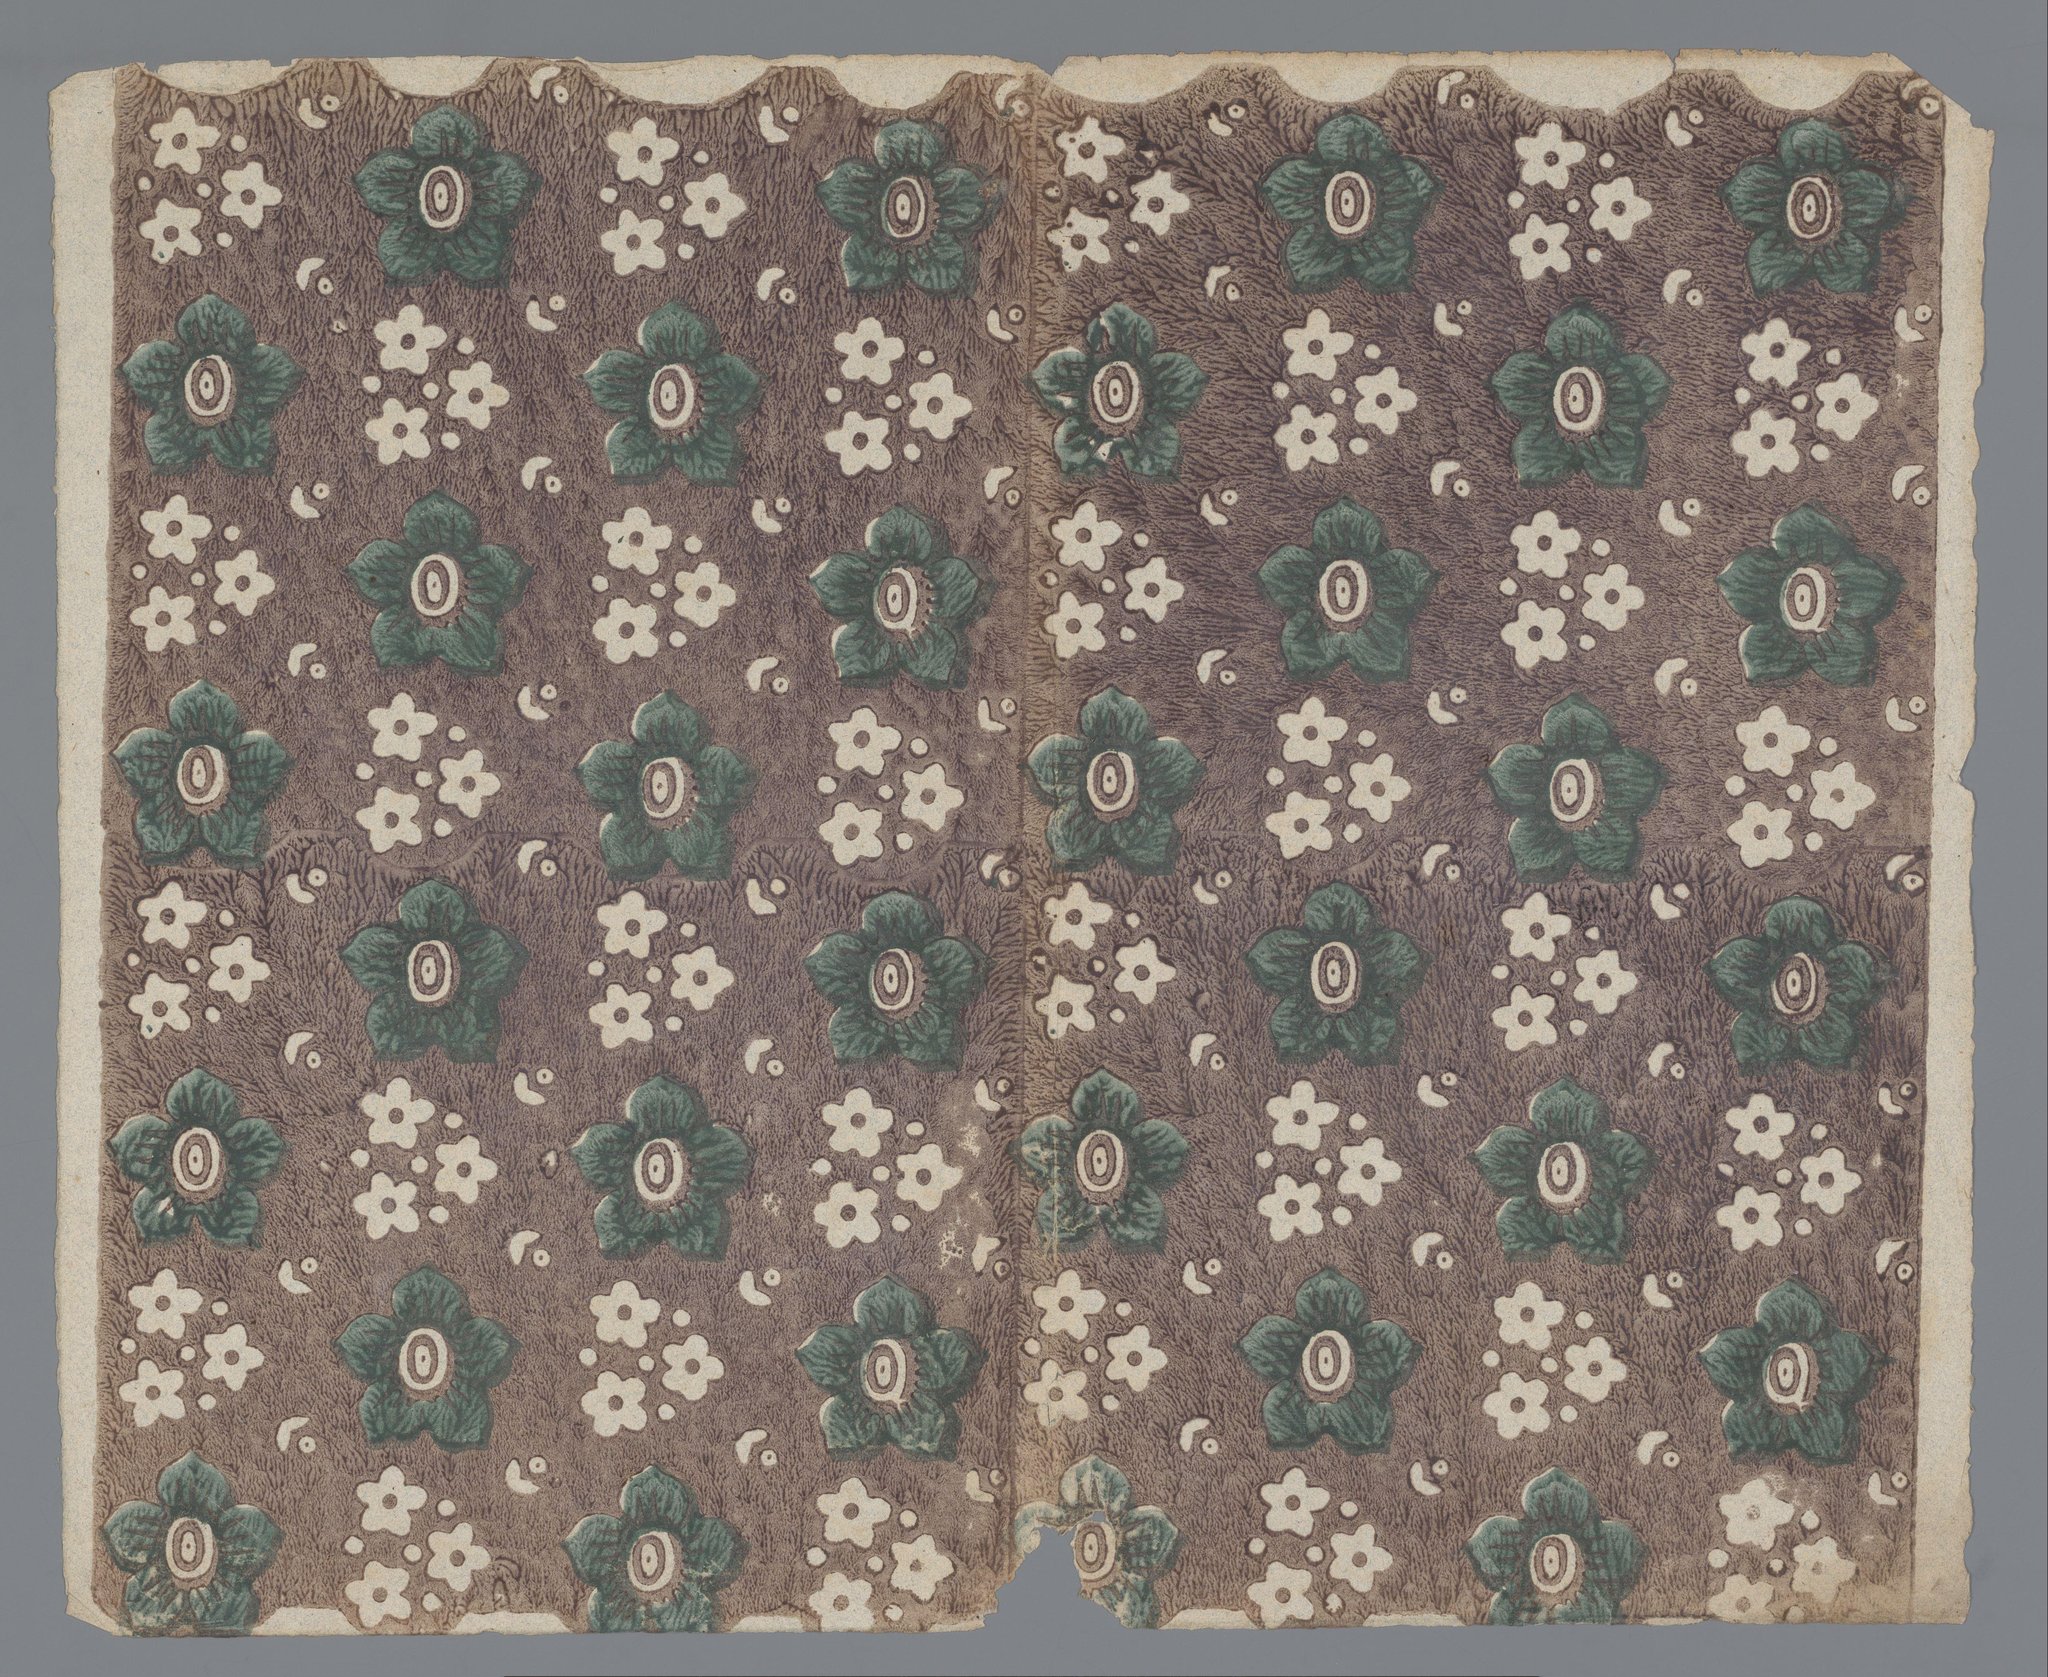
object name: paste paper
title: Blad met bloemenpatroon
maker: Anonymous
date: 1800-1900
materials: paper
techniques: printing block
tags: ornament derived from plant forms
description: Blad met patroon van grote en kleine bloemen. Gedrukt van twee hetzelfde blok. Mogelijk gebruikt als omslag.